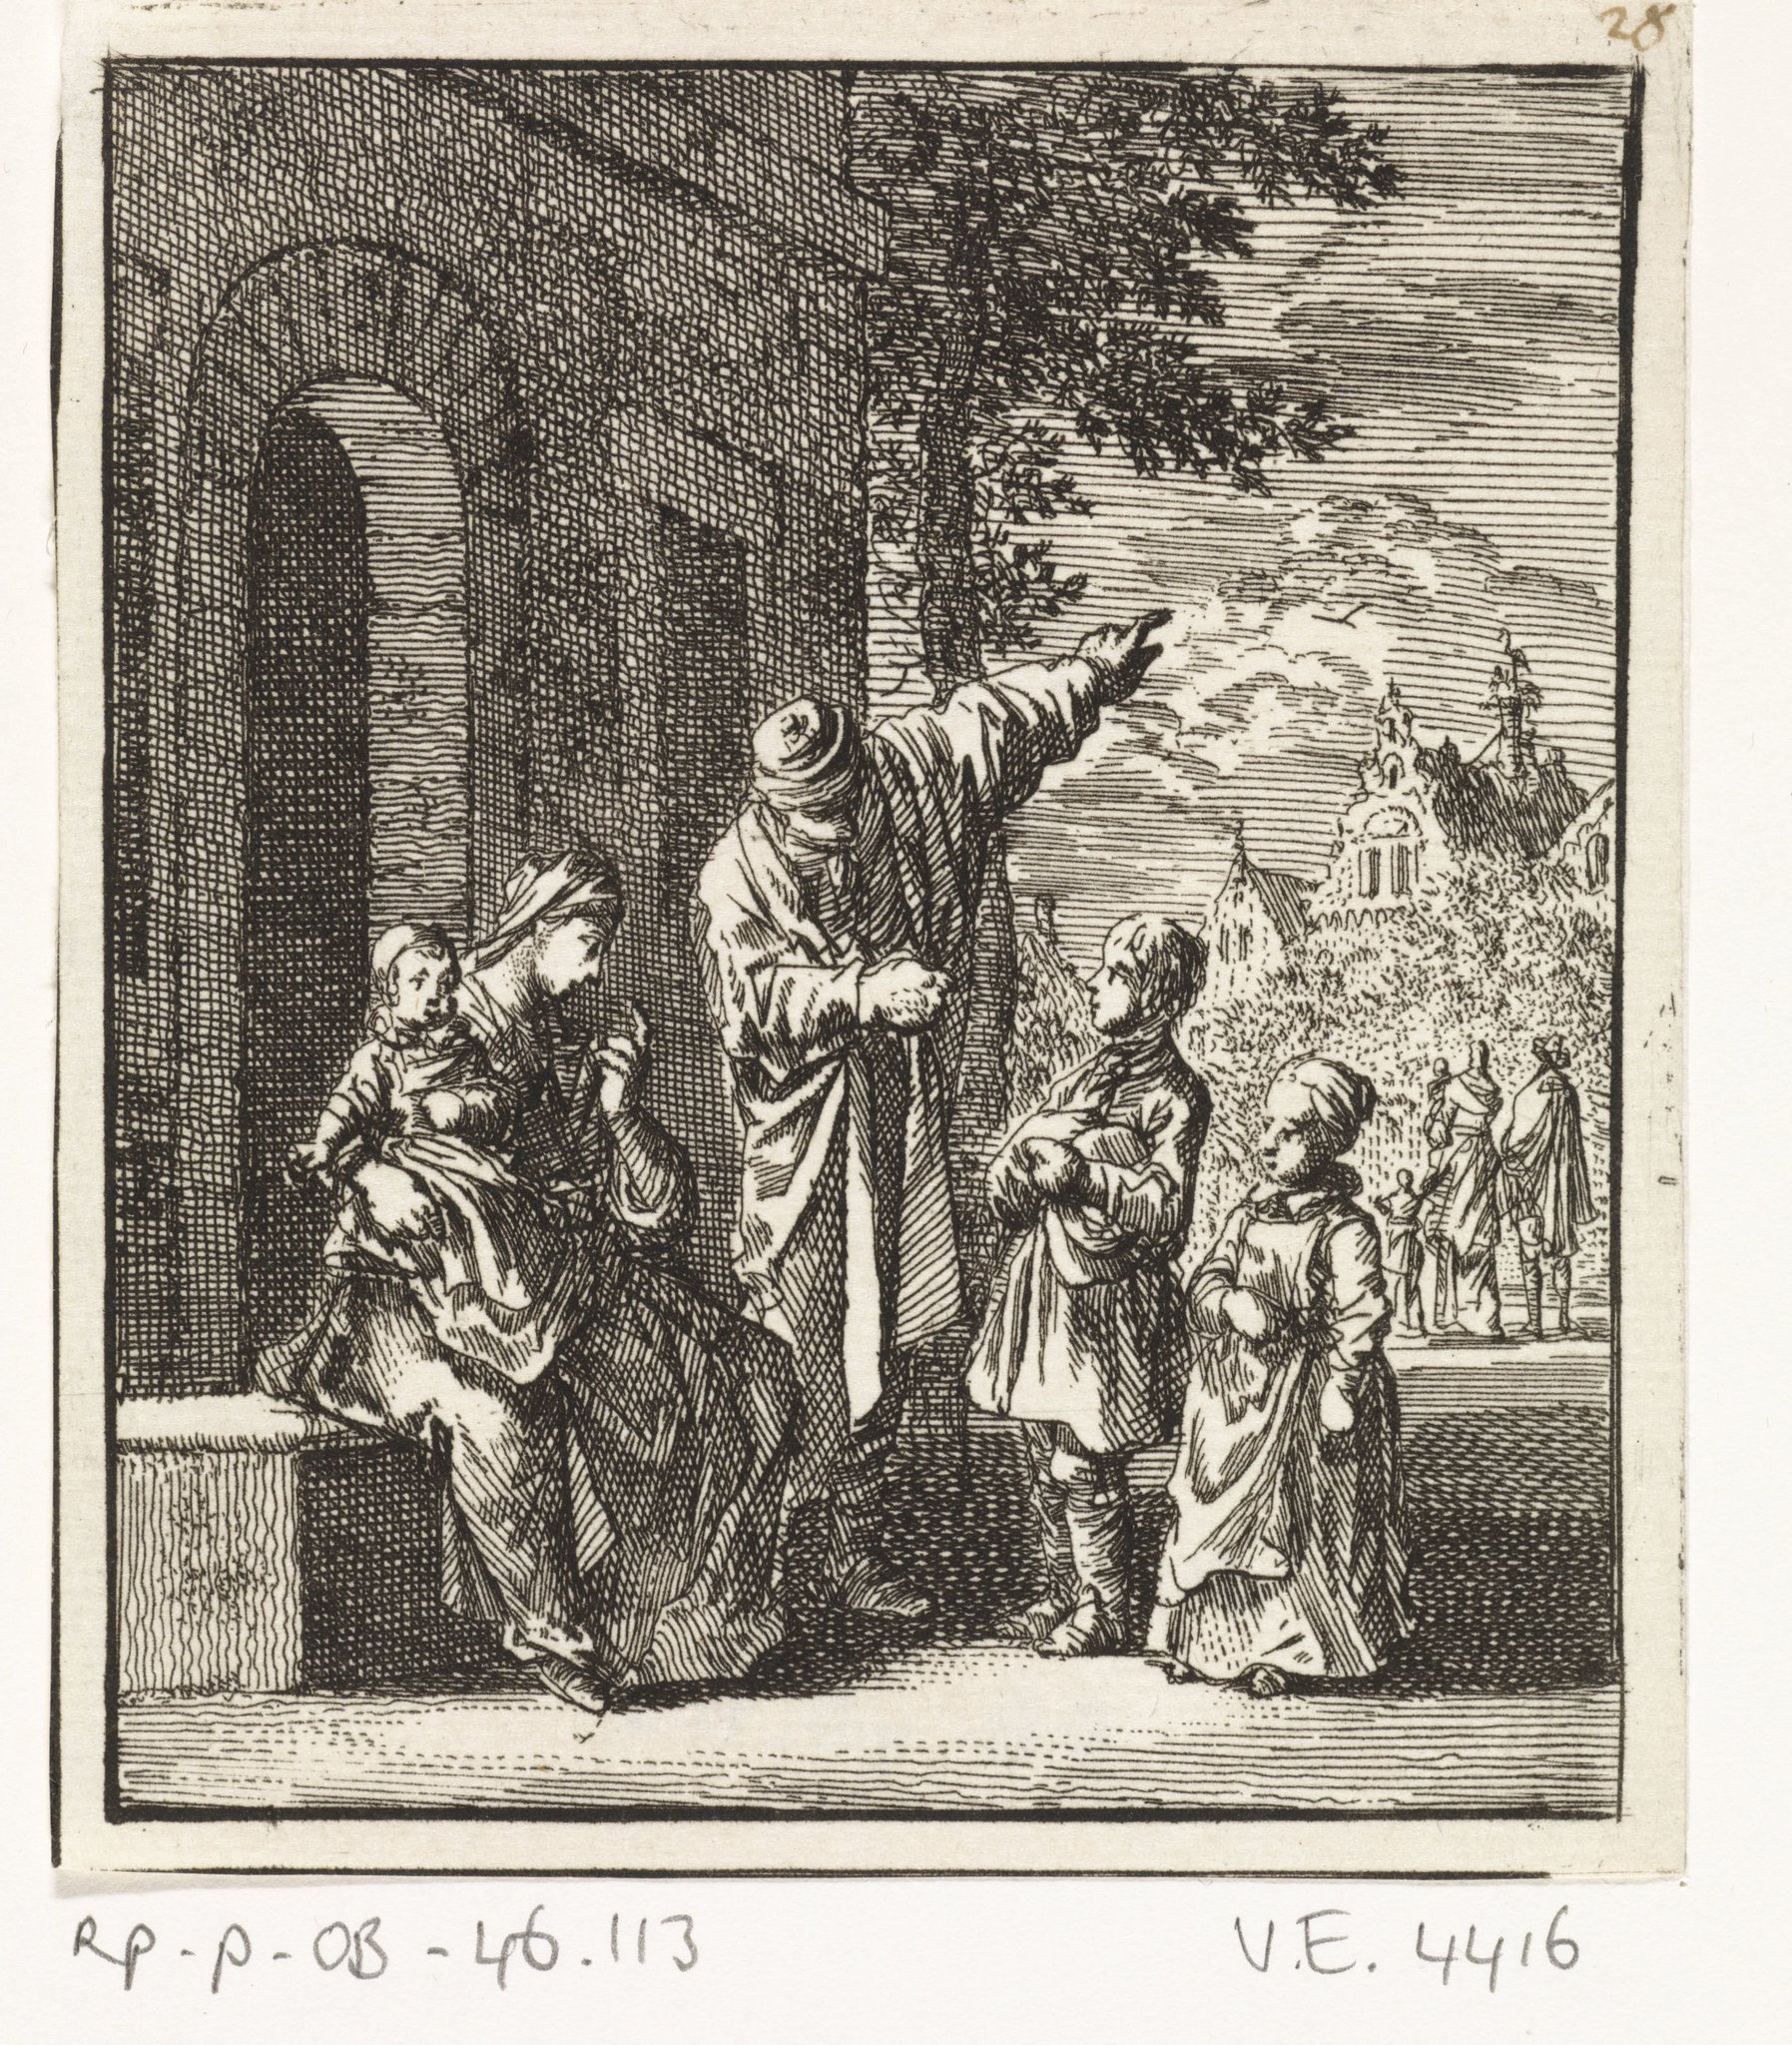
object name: print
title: Het Kind Gewaarschuwd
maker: jan luyken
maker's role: draughtsman, print maker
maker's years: 1649-1712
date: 1712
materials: paper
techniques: etching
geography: amsterdam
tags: children's games and plays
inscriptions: collector's mark: Lugt 2228, number: ‘28’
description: Proefdruk van illustratie uit: Luyken, Jan. Des menschen begin, midden en einde. Amsterdam: Wed. Pieter Arentsz II en Cornelis van der Sys, 1712, p. 59.